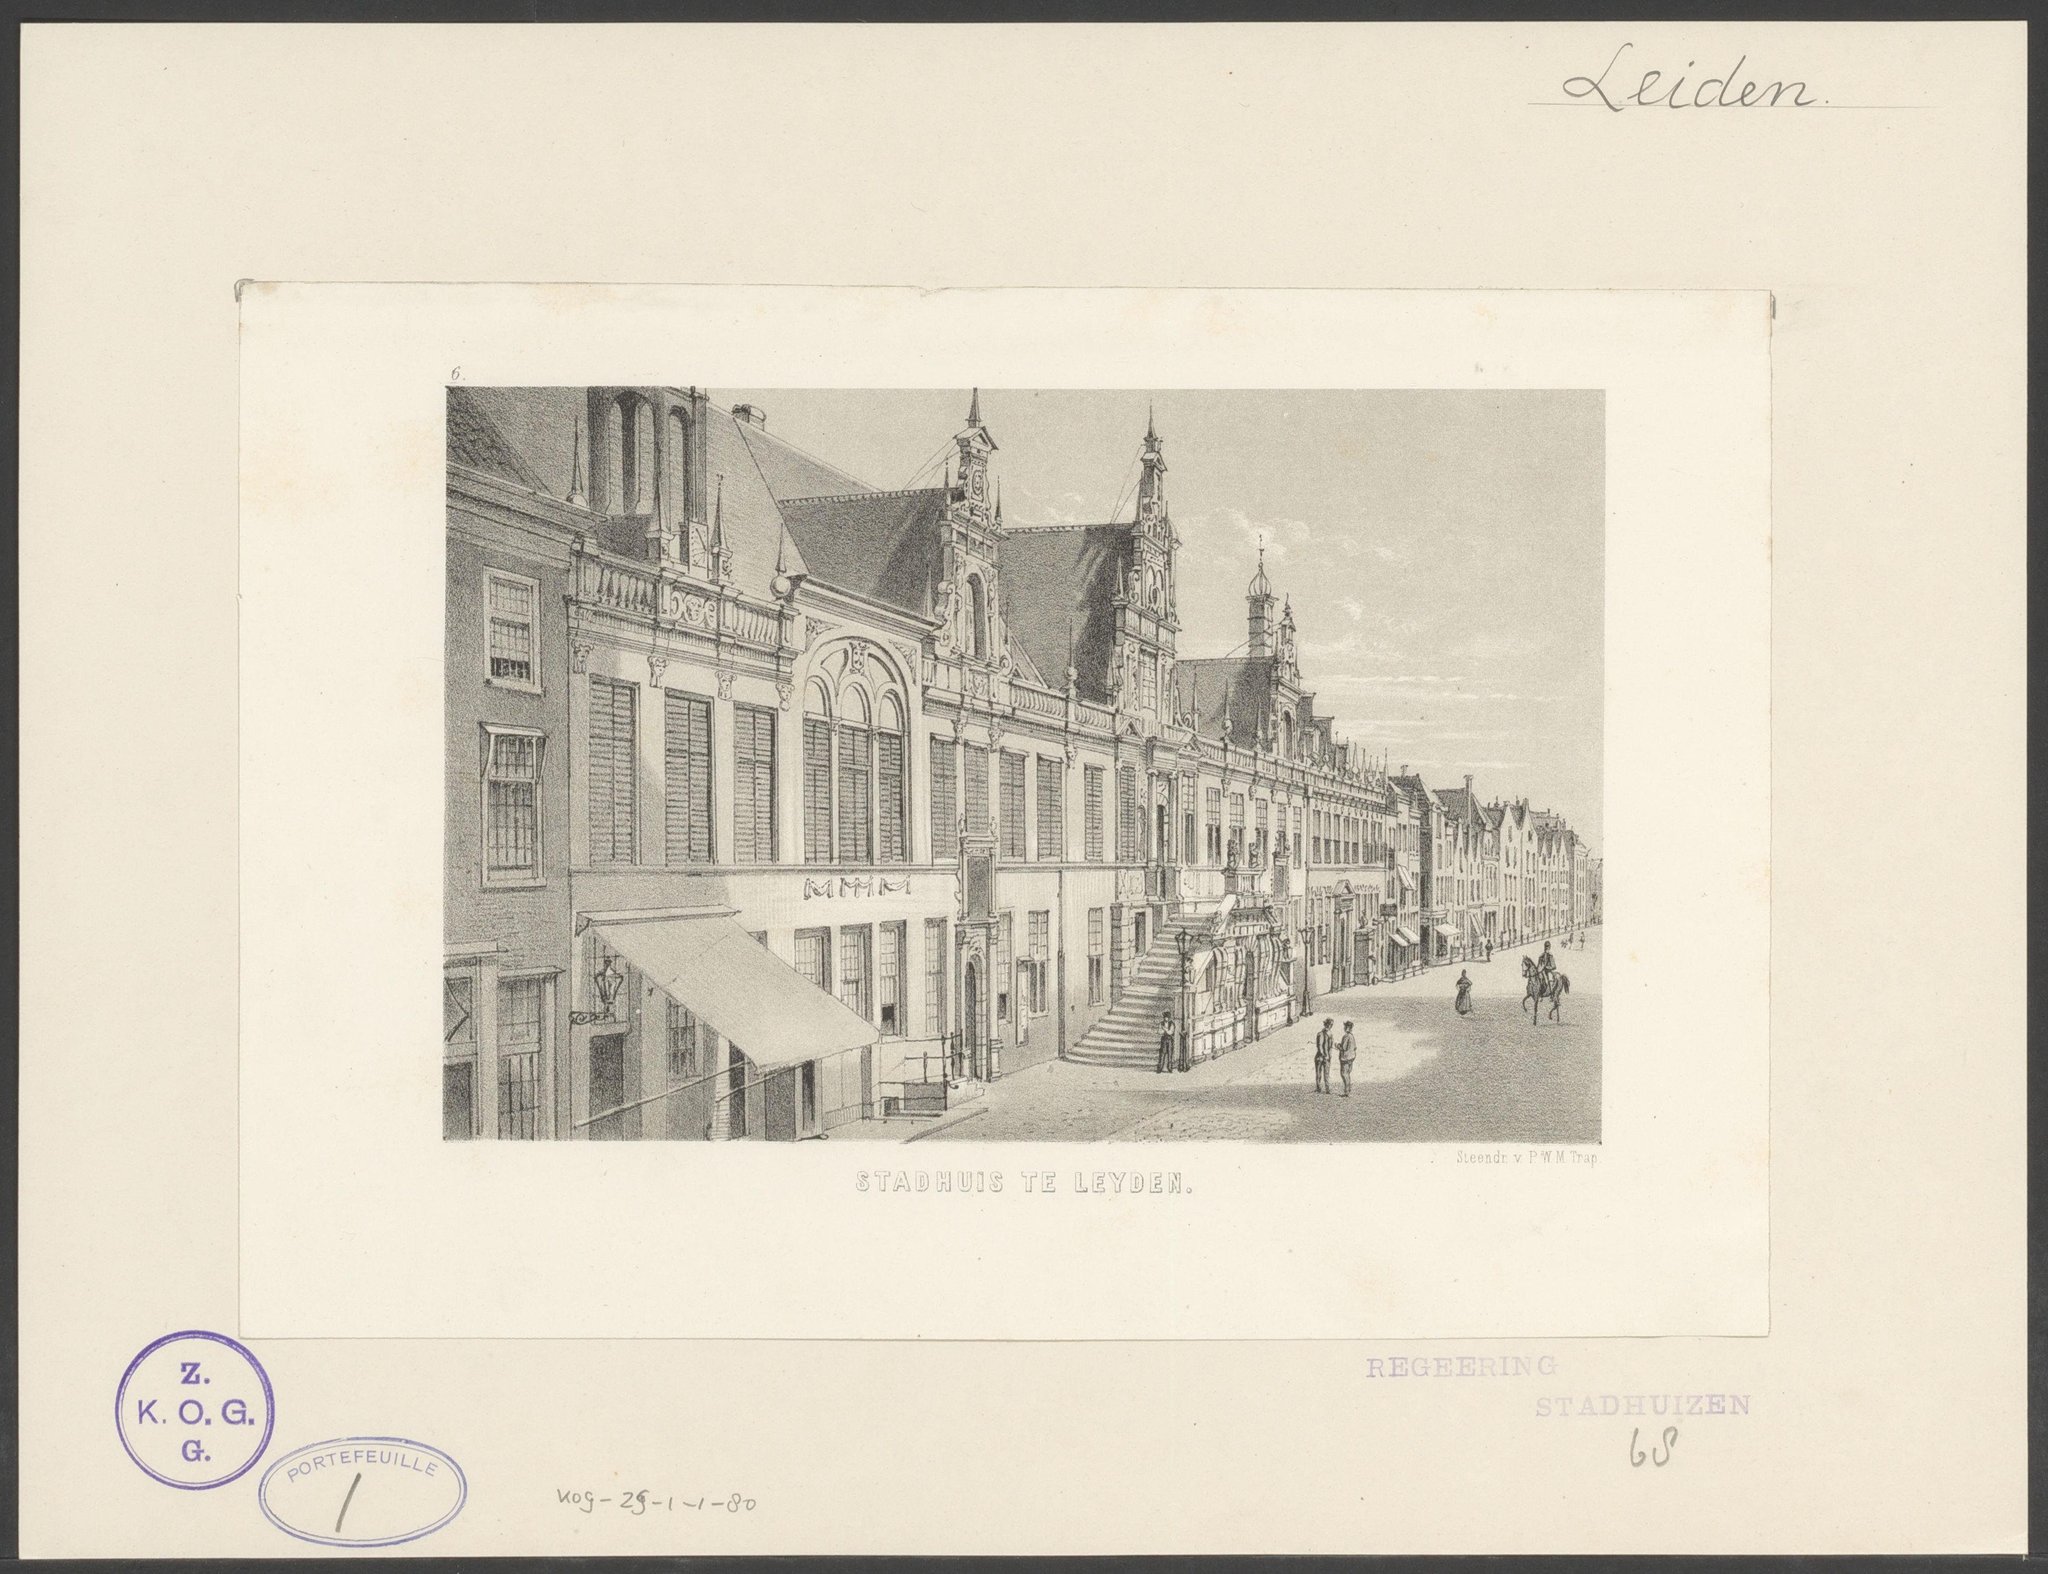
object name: print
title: Stadhuis te Leyden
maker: pieter willem marinus trap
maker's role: print maker, printer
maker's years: 1821-1905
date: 1840-1905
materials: paper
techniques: lithograph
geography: northern netherlands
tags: townhall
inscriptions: collector's mark, collector's mark: Lugt 1641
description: Gezicht op het Stadhuis in de Breestraat te Leiden. Onderwerpsrubrieken binnen de Atlas Zeden en Gewoonten: Regeering, Stadhuizen (H-M).